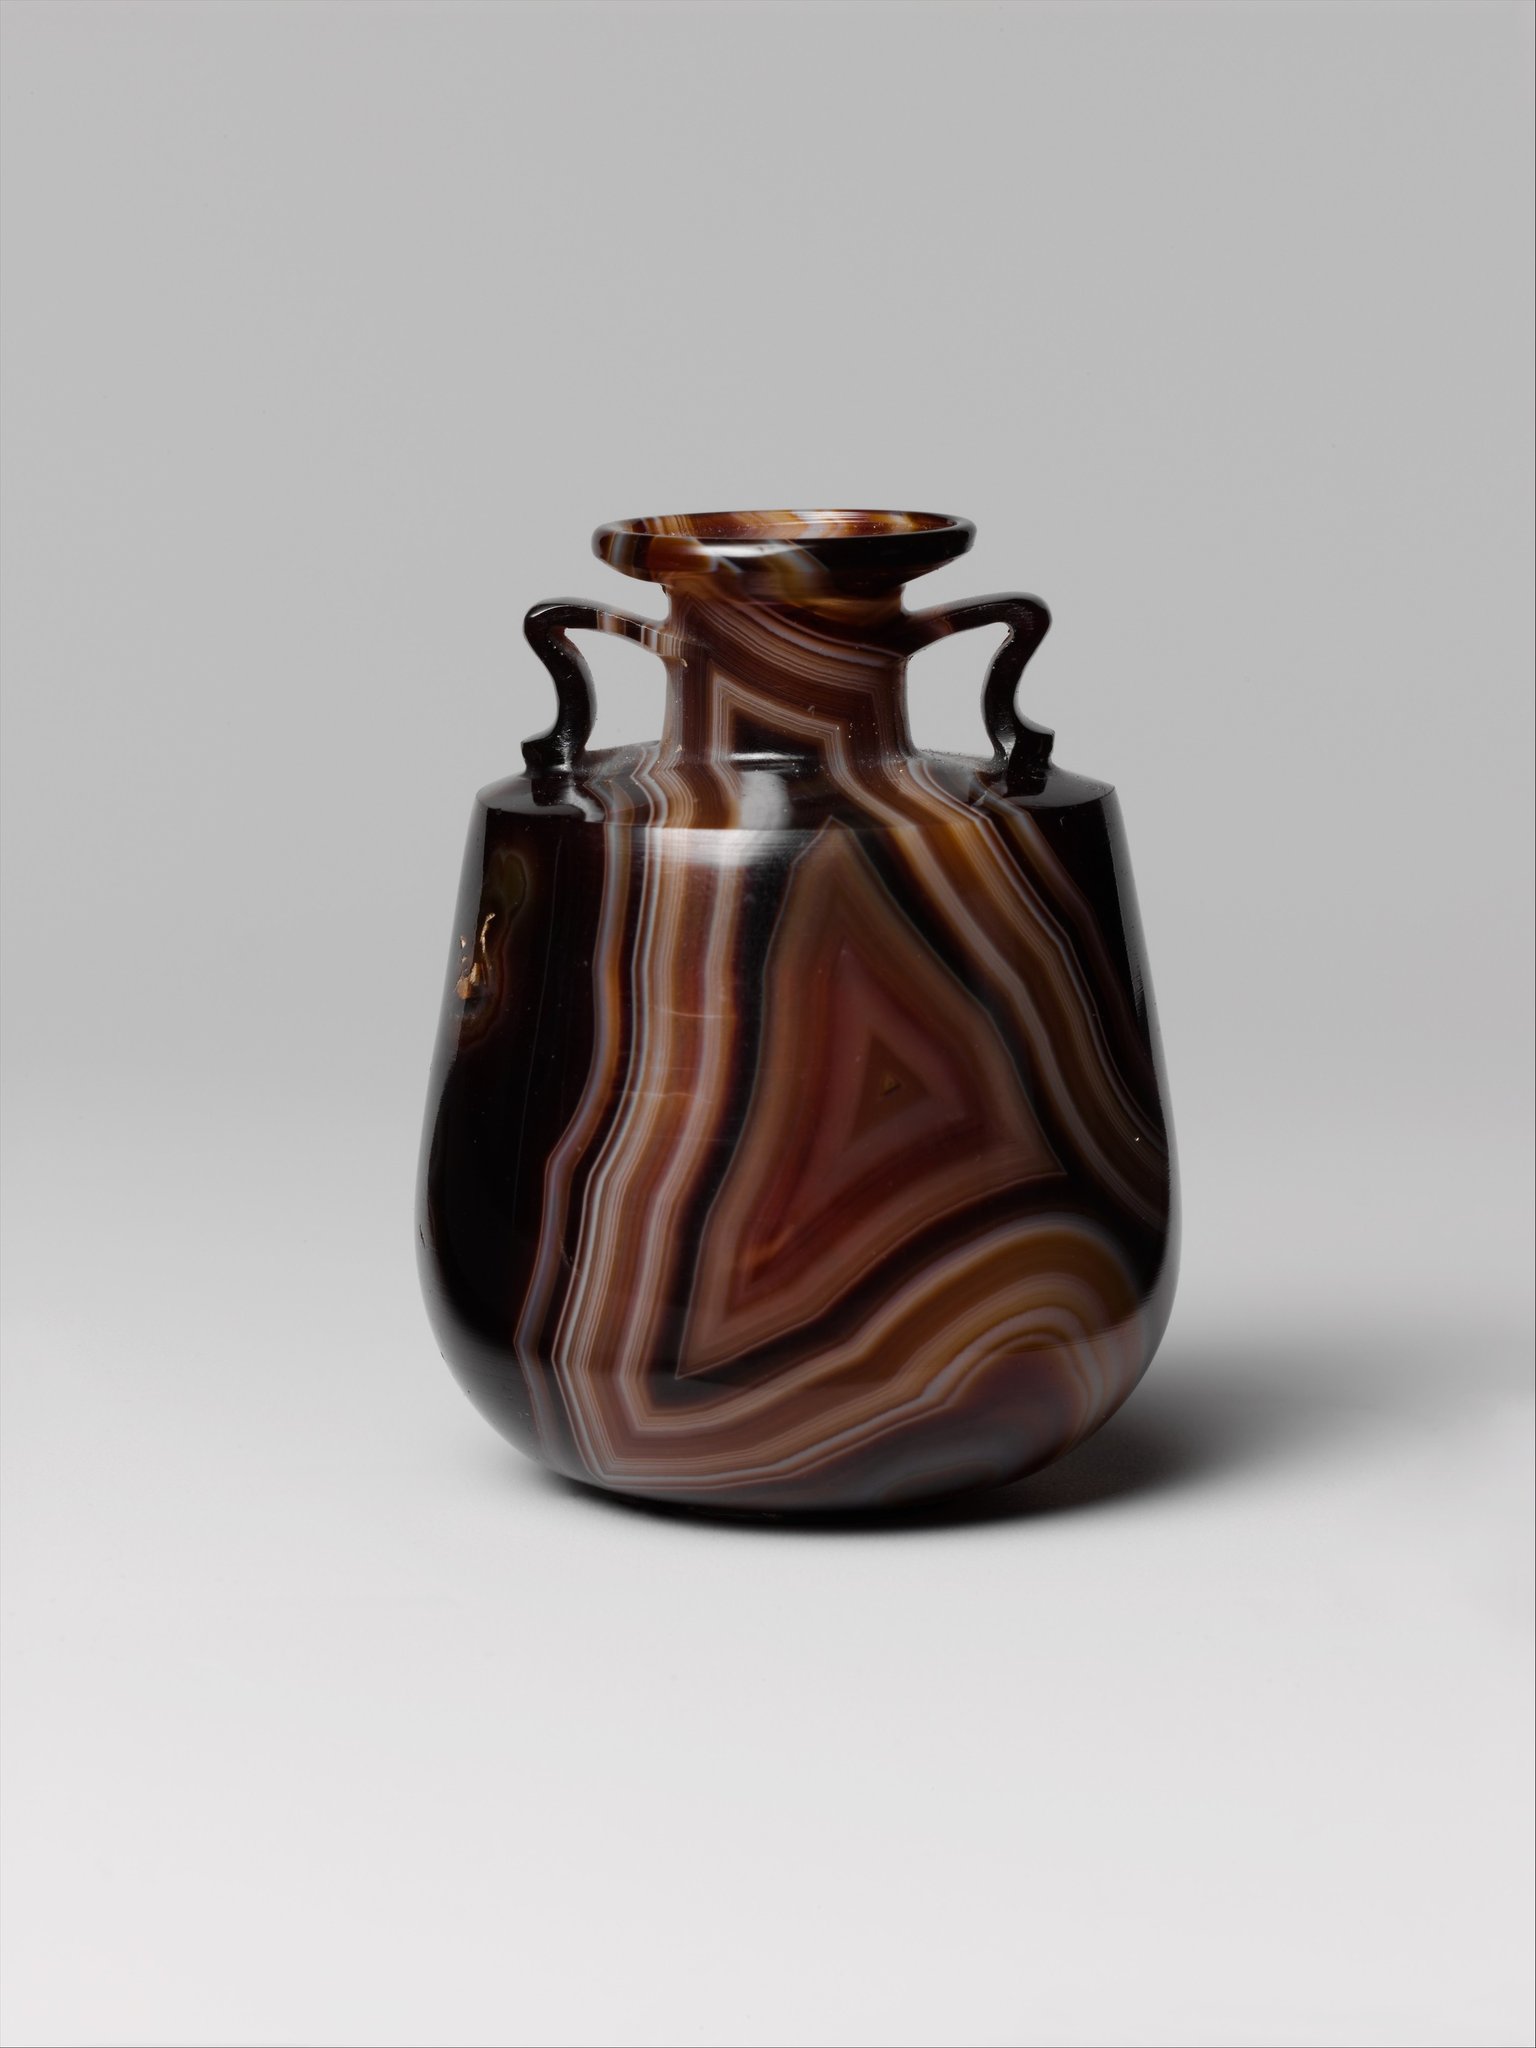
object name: amphora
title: Banded agate amphoriskos (perfume bottle)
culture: roman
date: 34 BCE-33 CE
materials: stone